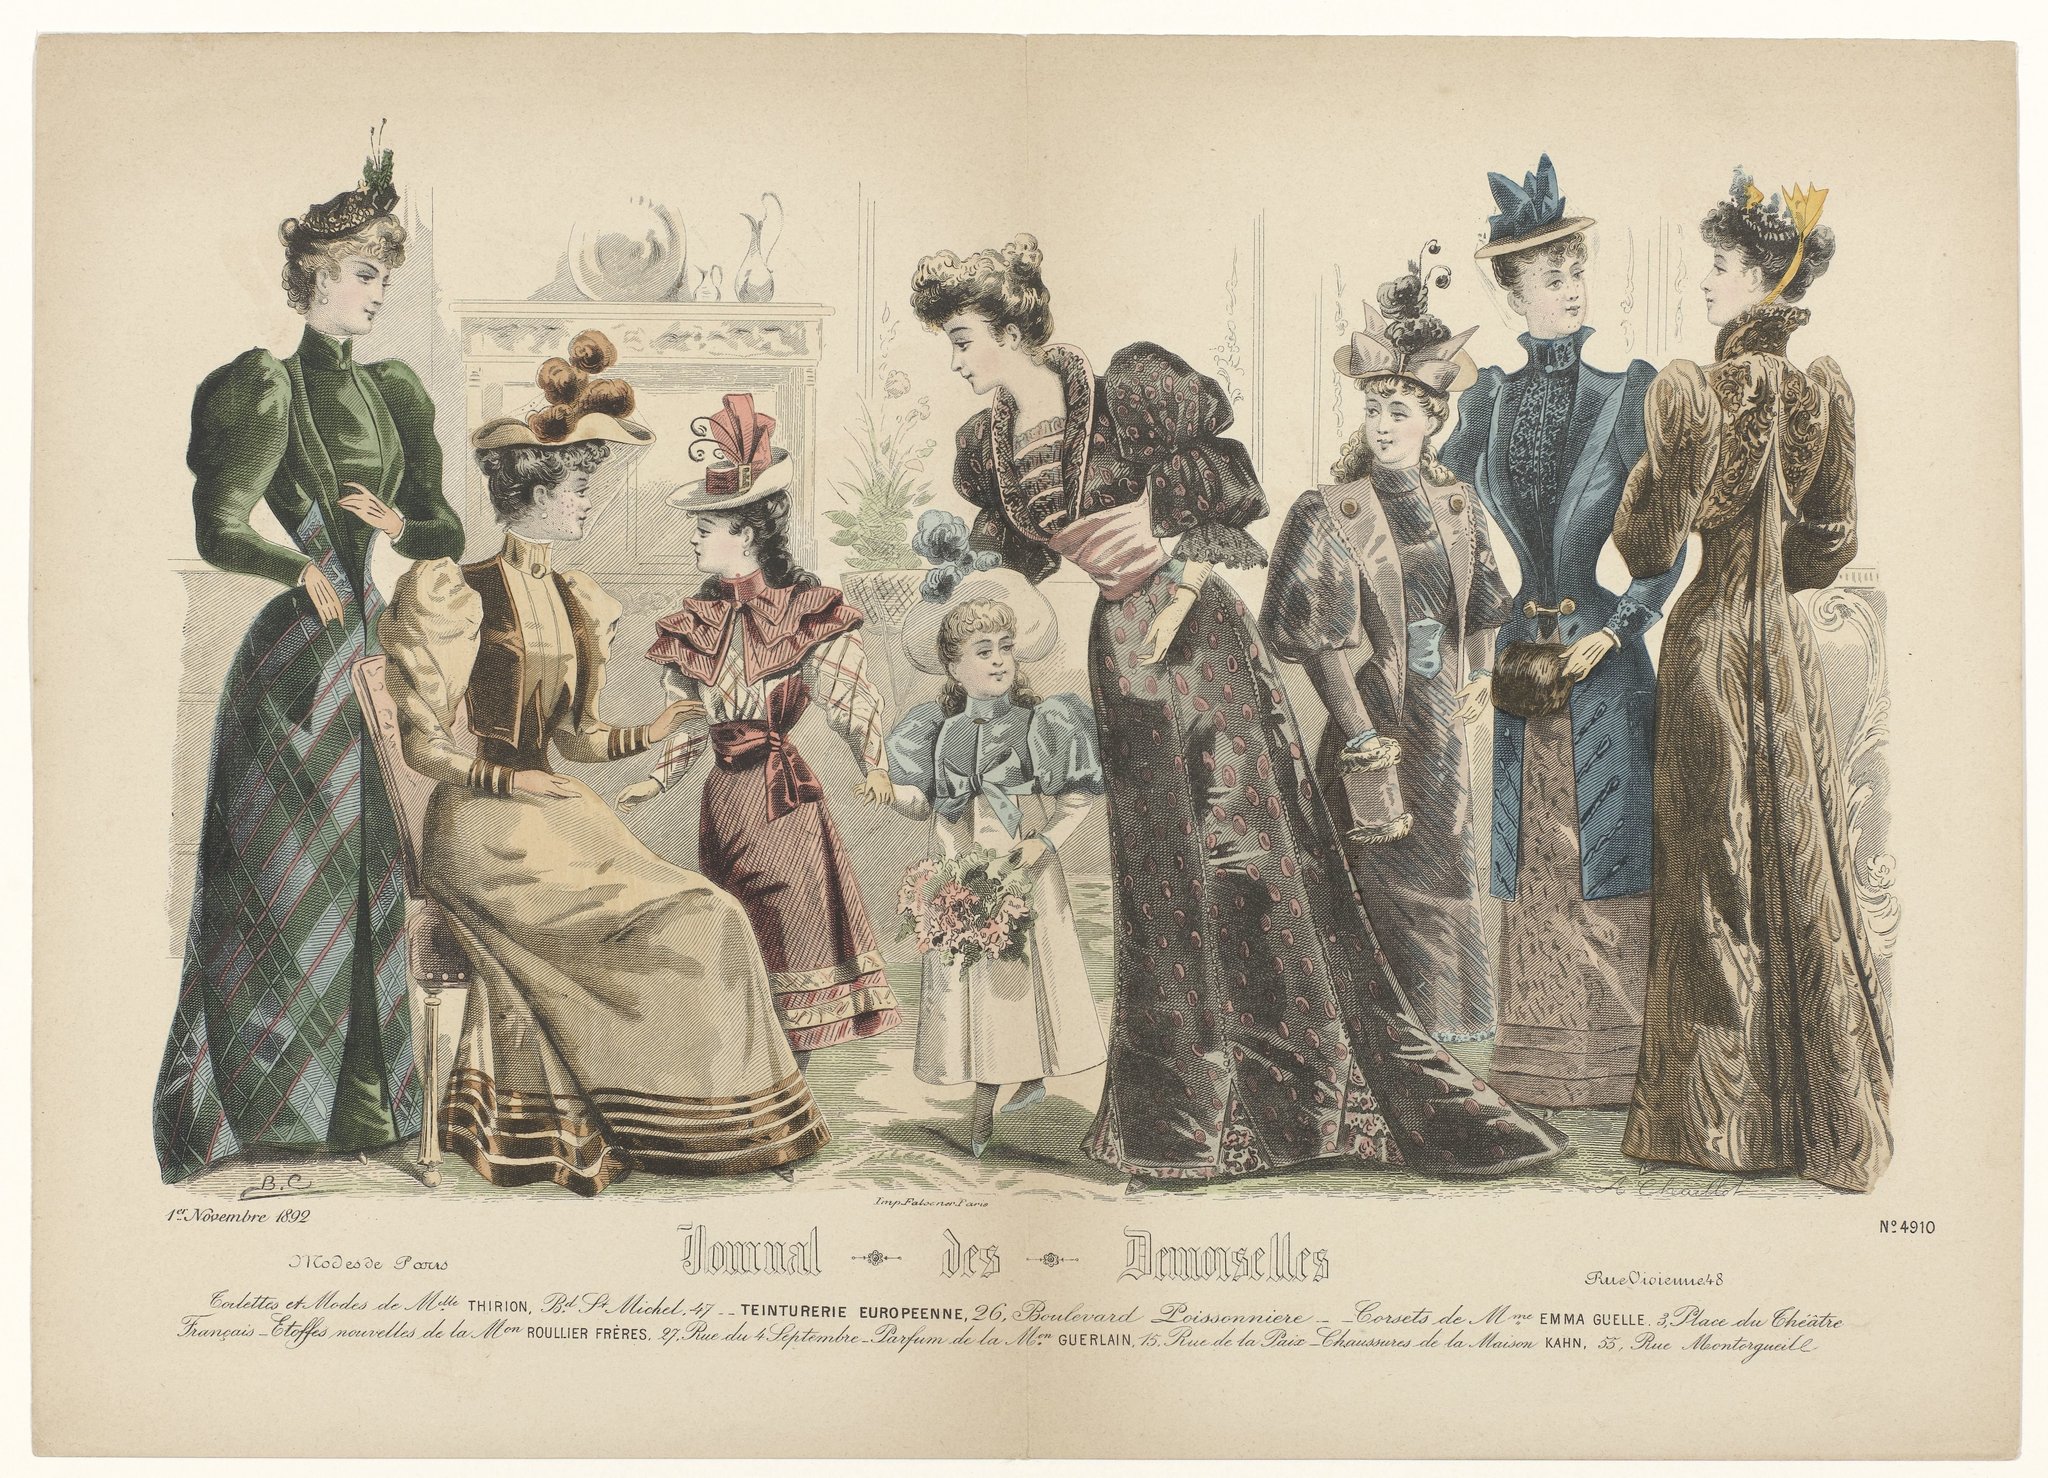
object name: fashion print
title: Journal des Demoiselles, 1 novembre 1892, No. 4910 : Toilettes et Modes (...)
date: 1892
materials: paper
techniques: engraving, hand coloring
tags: cut flowers; nosegay, bunch of flowers, veil (+ women's clothes), head-gear: hat (+ girls' clothes), muff (+ girls' clothes), coat (+ women's clothes), fashion plates, head-gear: hat (+ women's clothes), dress, gown (+ women's clothes), muff (+ fur used for clothes), dress, gown (+ girls' clothes)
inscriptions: caption: ‘Toilettes et Modes de M.elle Thirion, Bd St Michel,47_Teinturerie Europeenne,26,Boulevard Poissonniere__Corsets de Mme Emma Guelle,3 Place du théâtre Français_Etoffes nouvelles de la Mon Roullier frères,27.Rue du 4 Septembre_Parfum de la Mon. Guerlain,15. Rue de la Paix_Chaussures de la Maison Kahn, 55, Rue Montorgueil.’, title: ‘Modes de Paris / Journal des Demoiselles / Rue Vivienne 48’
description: Vijf vrouwen en drie meisjes in een interieur. Volgens het onderschrift: 'toilettes' en 'modes' van Thirion. Hieronder enkele regels reclametekst voor verschillende producten. Prent uit het modetijdschrift Journal des Demoiselles (1833 -1922).